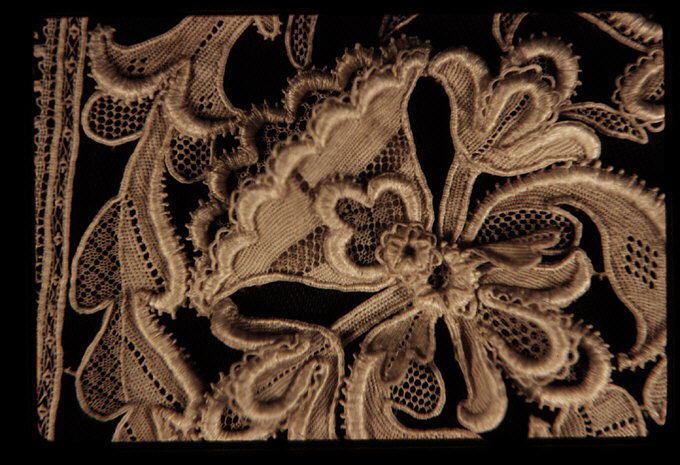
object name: fragment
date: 1850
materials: lace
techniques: gros point, lace